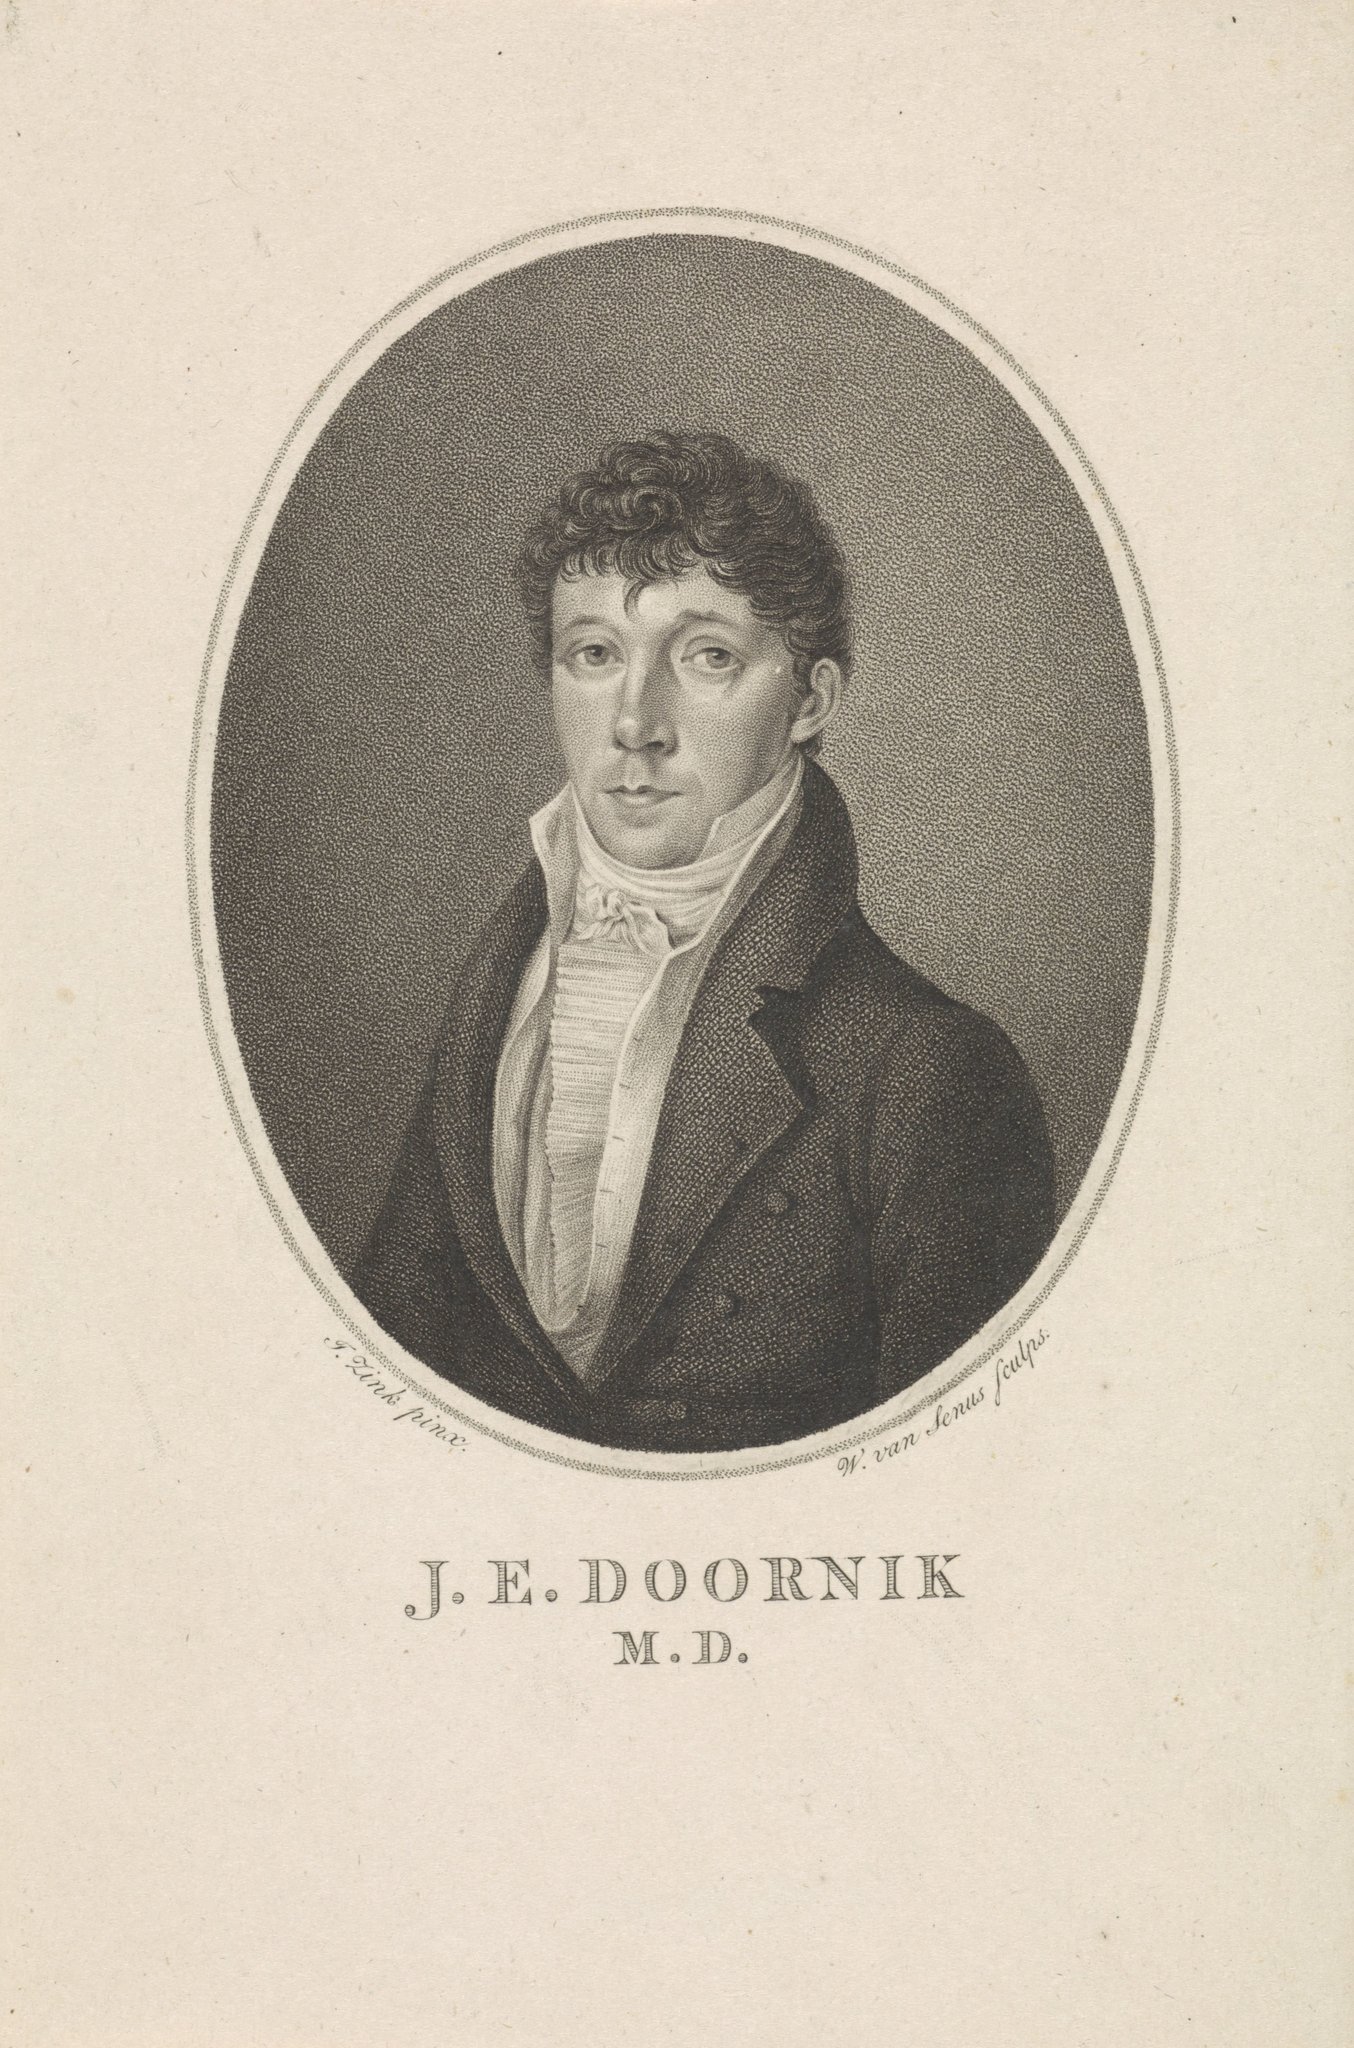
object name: print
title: Portret van Jacob Elisa Doornik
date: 1797-1851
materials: paper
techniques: engraving, etching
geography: netherlands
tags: new orleans, professor, jacob elisa doornik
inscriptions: collector's mark: Lugt 2228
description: Portret van Jacob Elisa Doornik, doctor in de medicijnen.